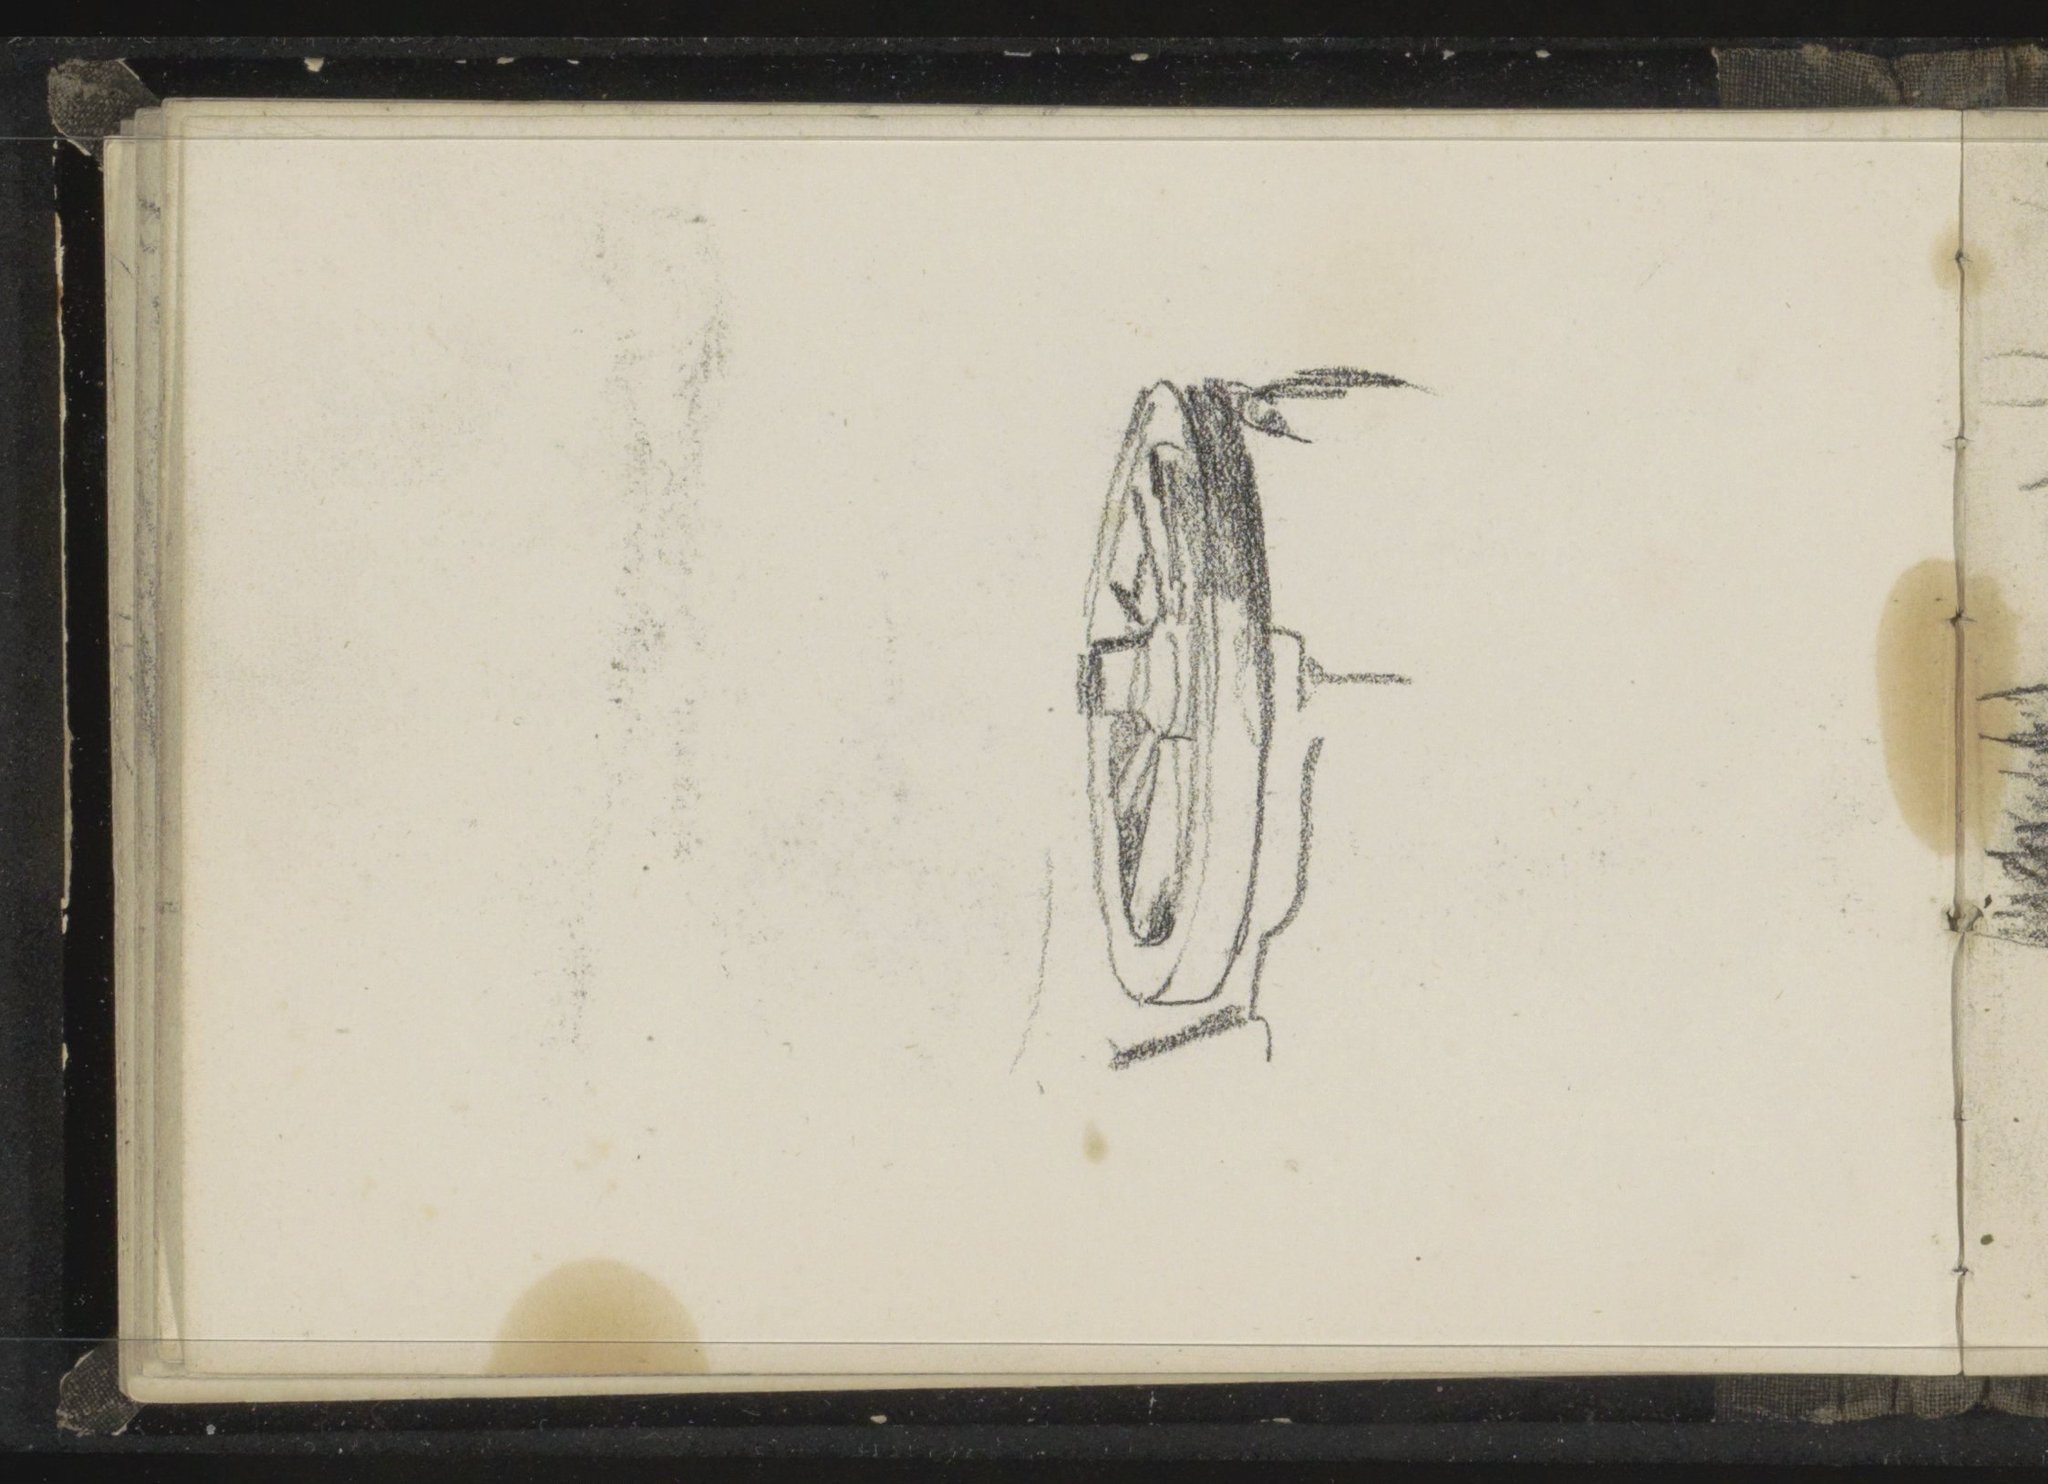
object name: sketchbook leaf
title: Wagenwiel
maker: anton mauve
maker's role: draughtsman, painter, print maker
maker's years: 1838-1888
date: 1848-1888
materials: chalk, paper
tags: wheel (of vehicle)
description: Blad 23 verso uit een schetsboek met 33 bladen.